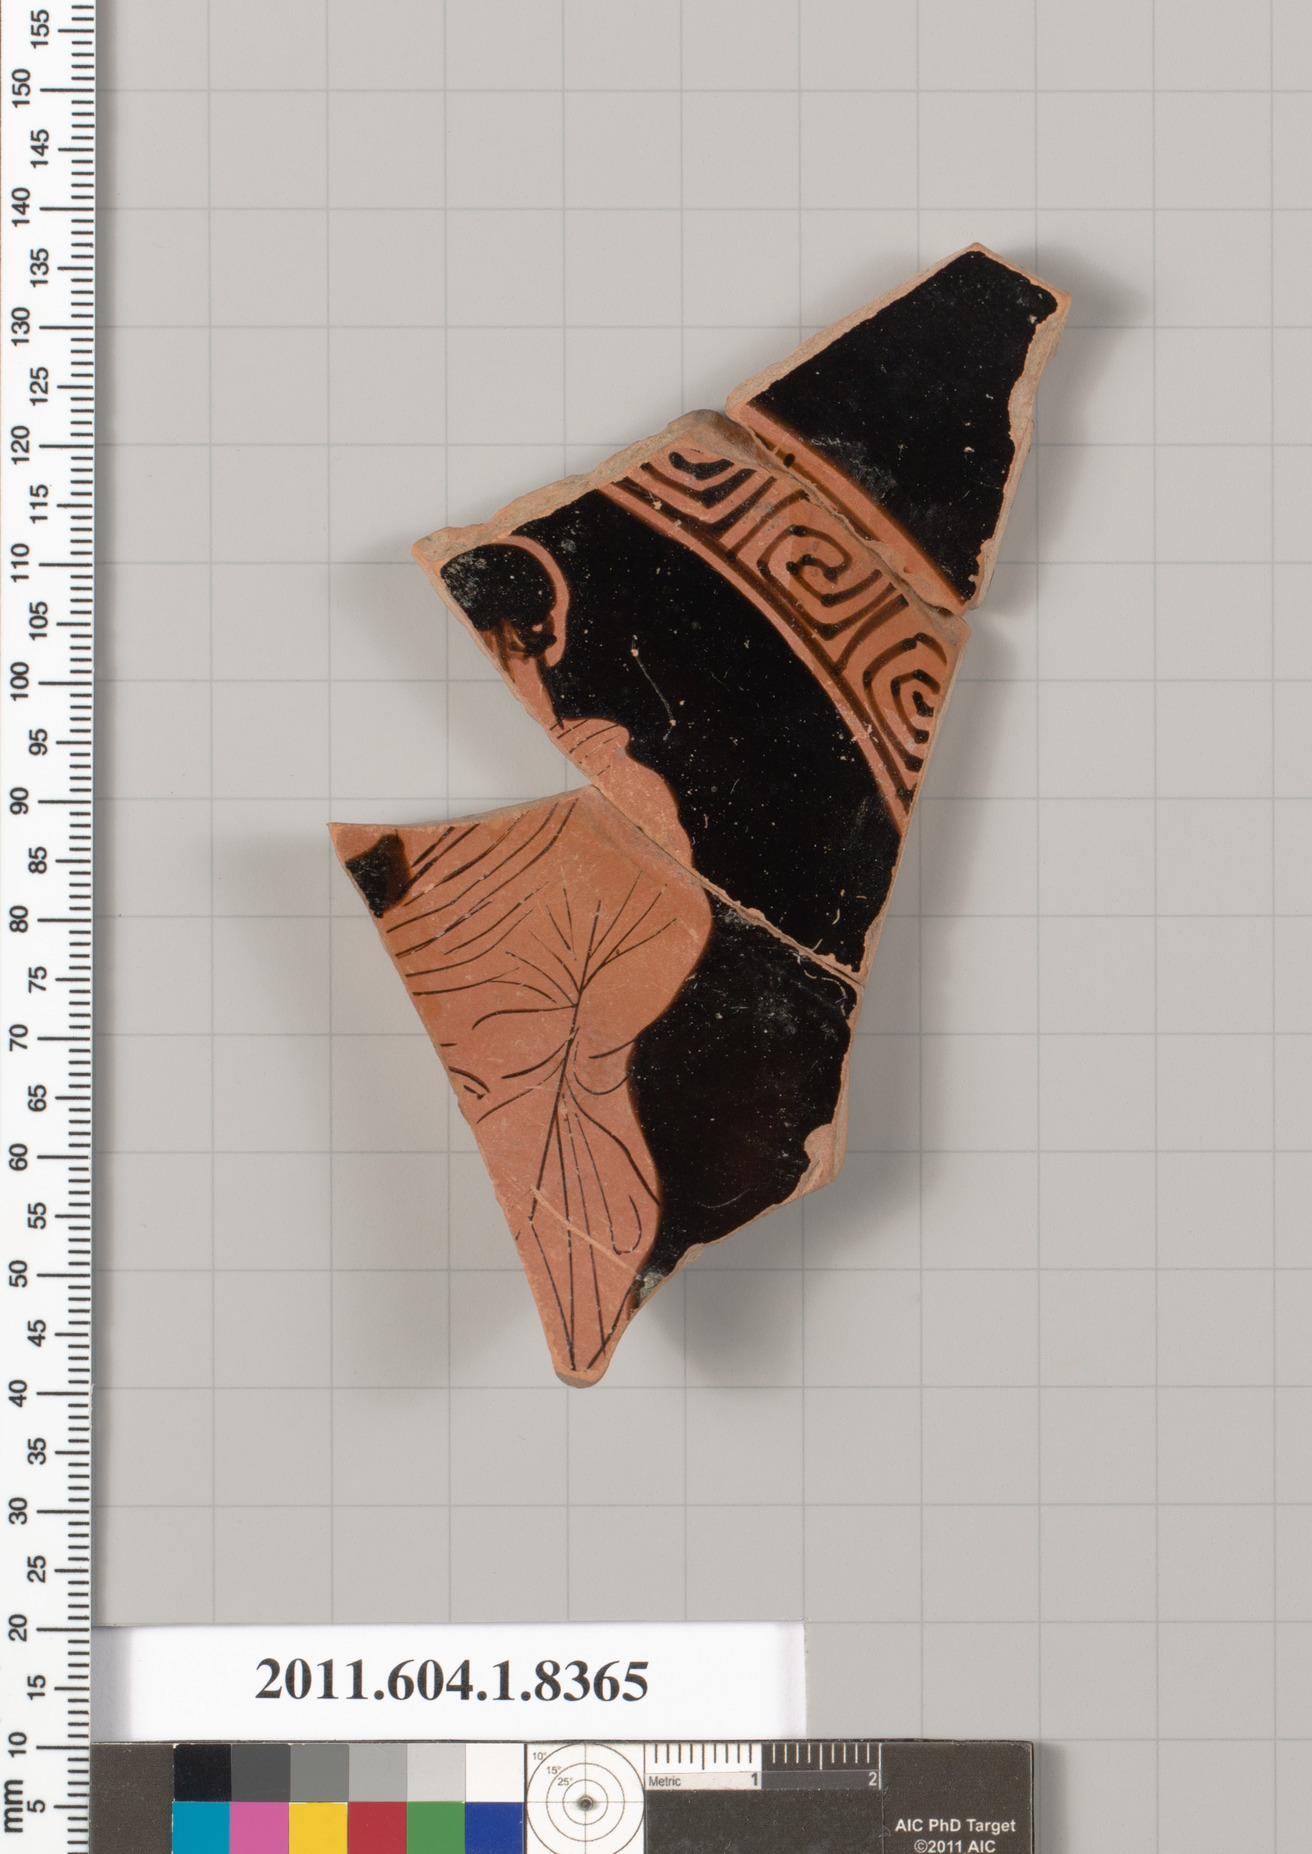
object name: kylix fragment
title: Terracotta fragment of a kylix (drinking cup)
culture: greek, attic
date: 400-376 BCE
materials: terracotta